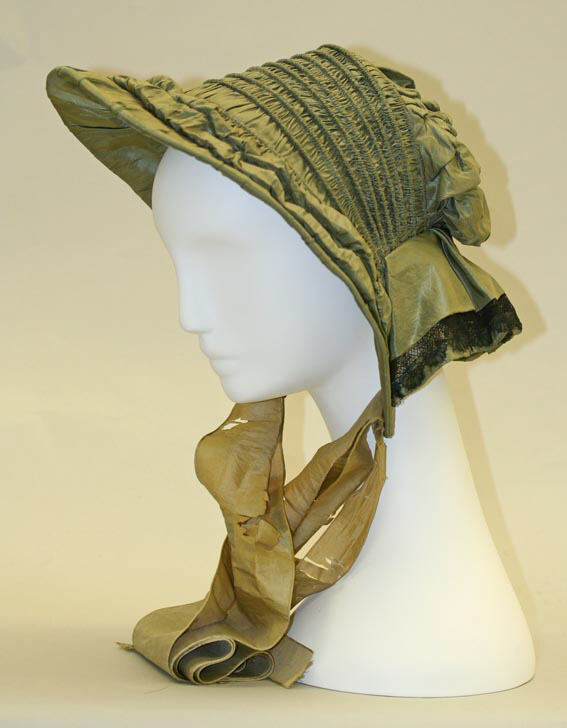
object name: poke bonnet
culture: american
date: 1860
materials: silk